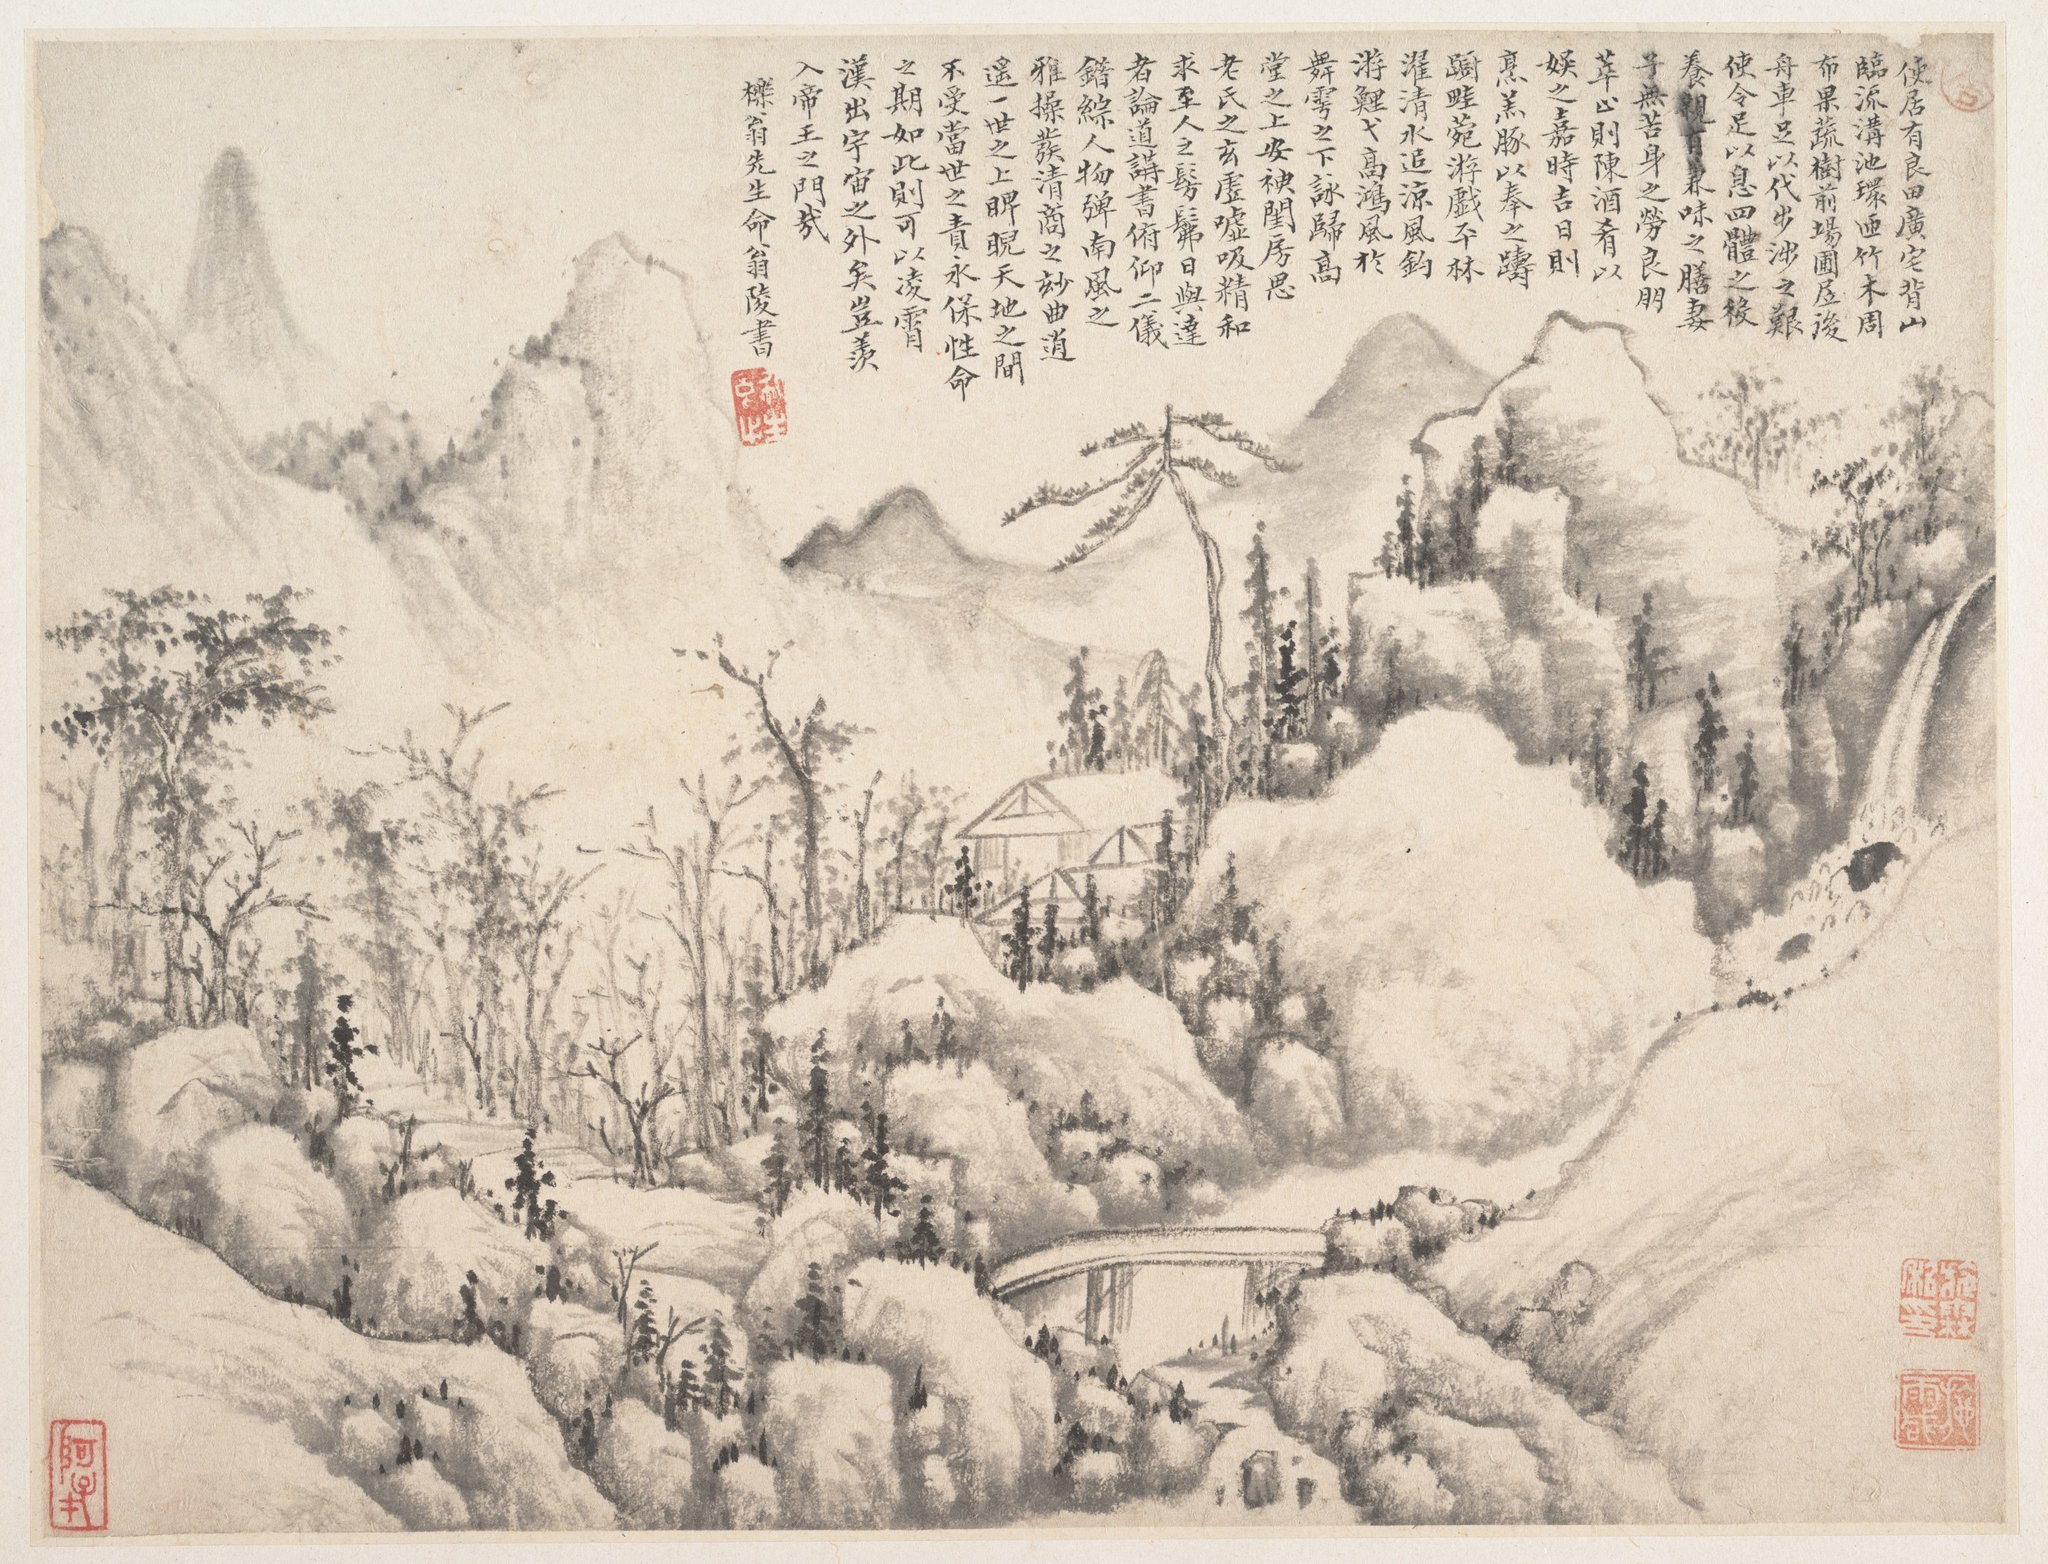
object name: album leaf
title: Mountain Retreat, leaf from Album for Zhou Lianggong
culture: chinese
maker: shi lin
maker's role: artist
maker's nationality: chinese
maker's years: 1610-1670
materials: ink, paper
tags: mountains,landscapes